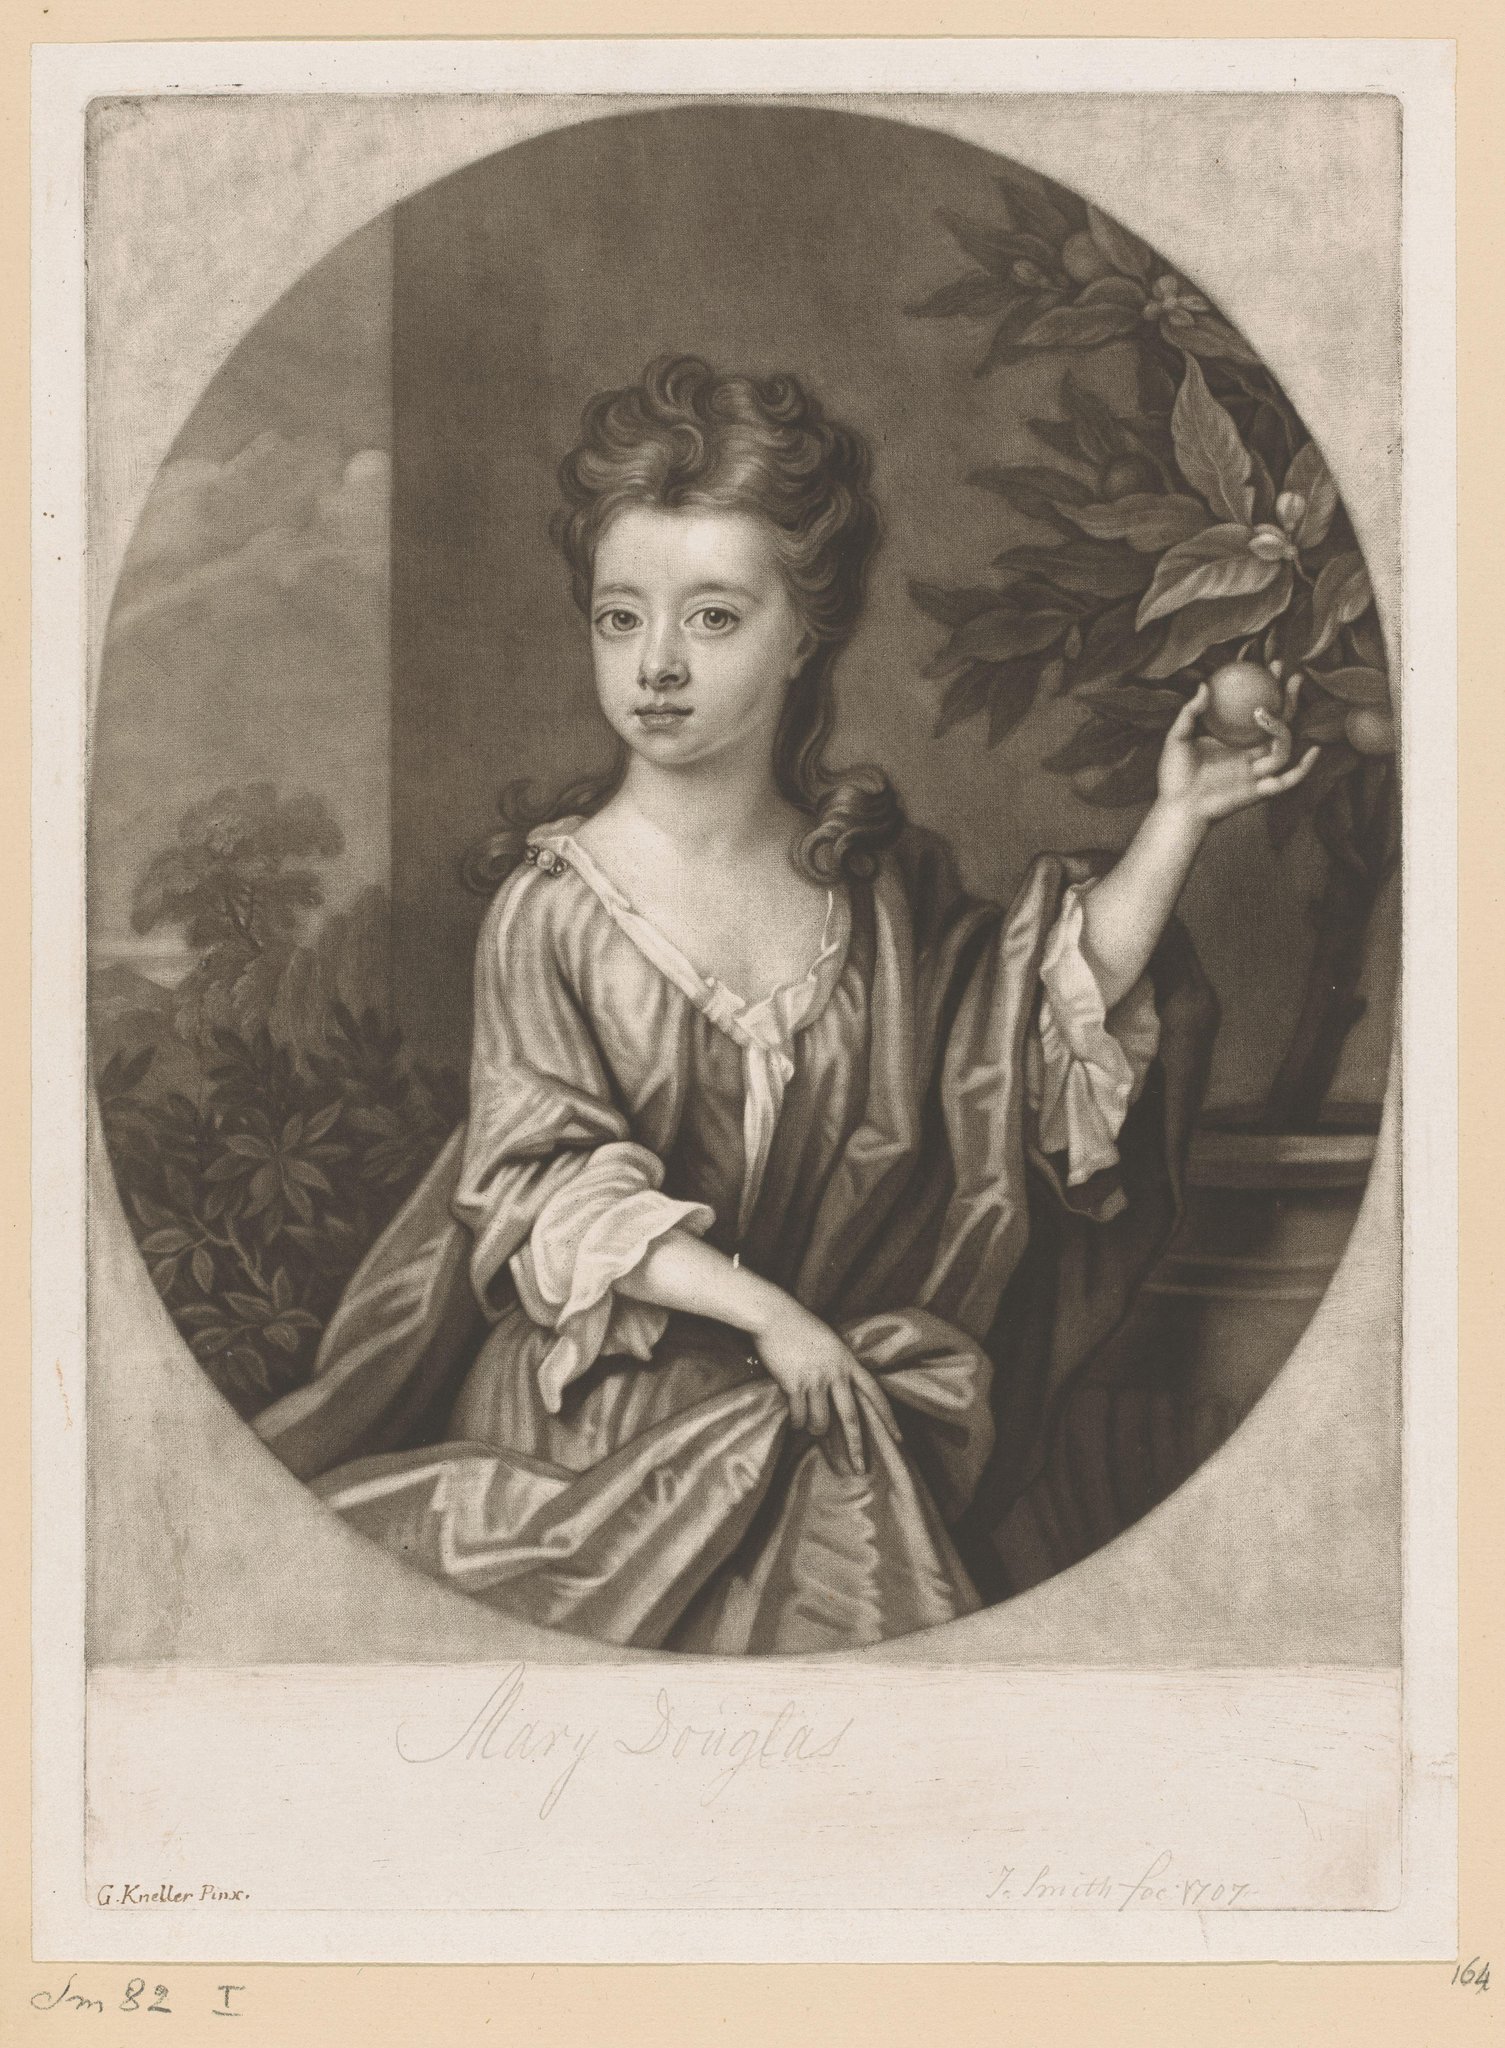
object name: print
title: Lady Mary Douglas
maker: john smith (prentmaker/ uitgever)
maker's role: print maker, publisher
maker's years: 1652-1743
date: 1705-1742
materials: paper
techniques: mezzotint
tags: historical persons, girl (child between toddler and youth)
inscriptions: collector's mark: Lugt 240